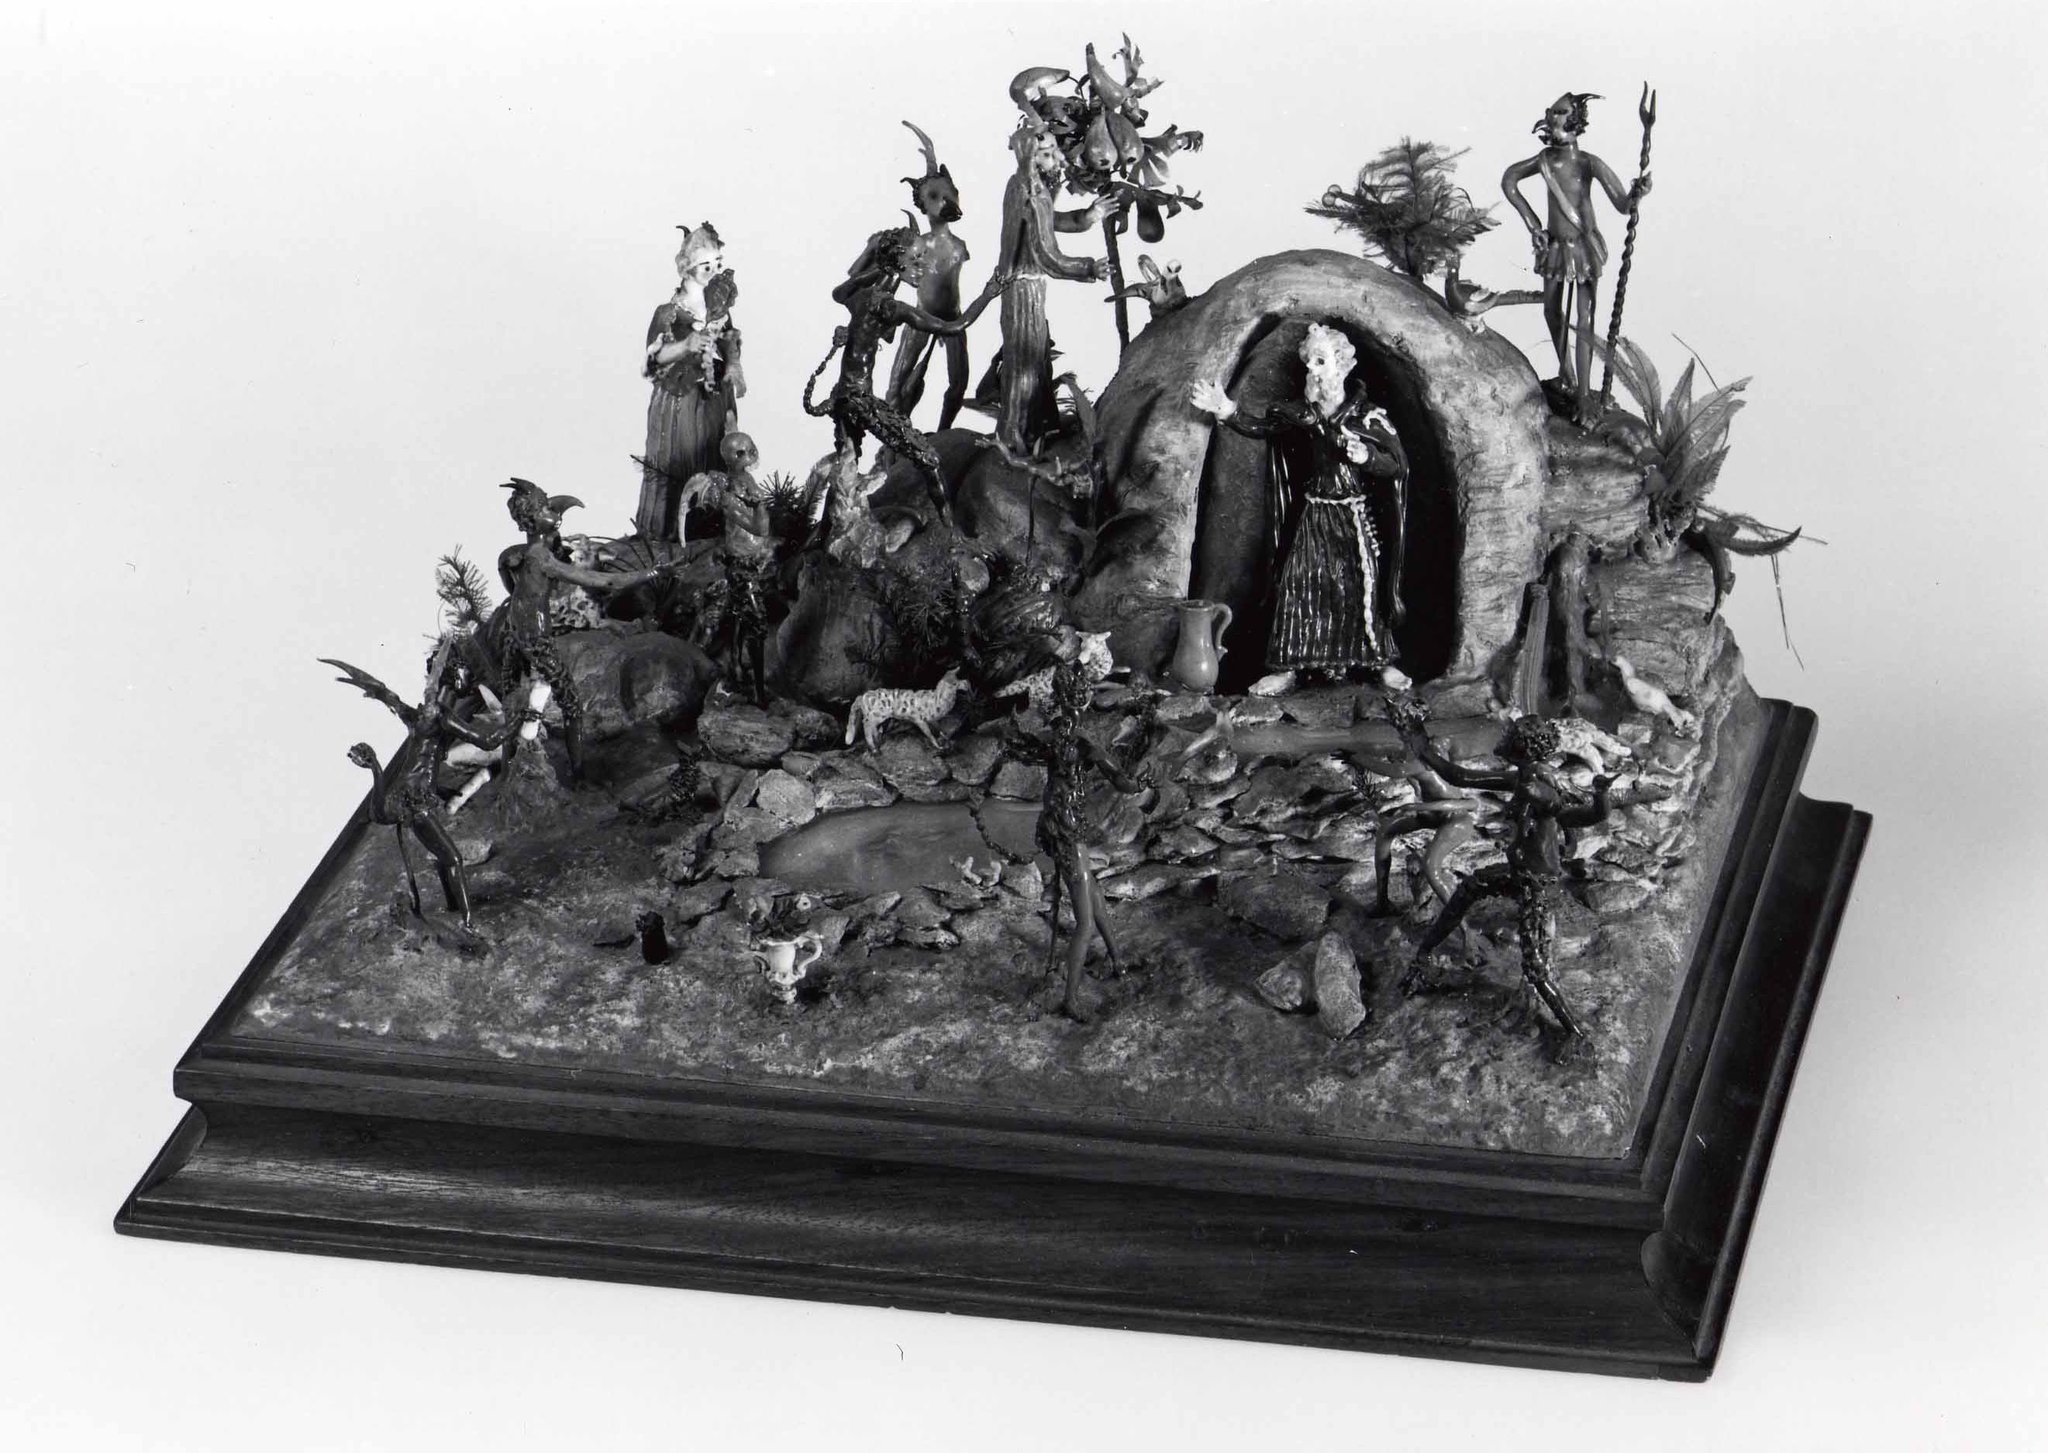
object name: figurine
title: The Temptation of St. Anthony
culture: french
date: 1701-1800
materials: feather, glass, paint, paper, shell, metal, wood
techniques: lampwork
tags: animals,saint anthony